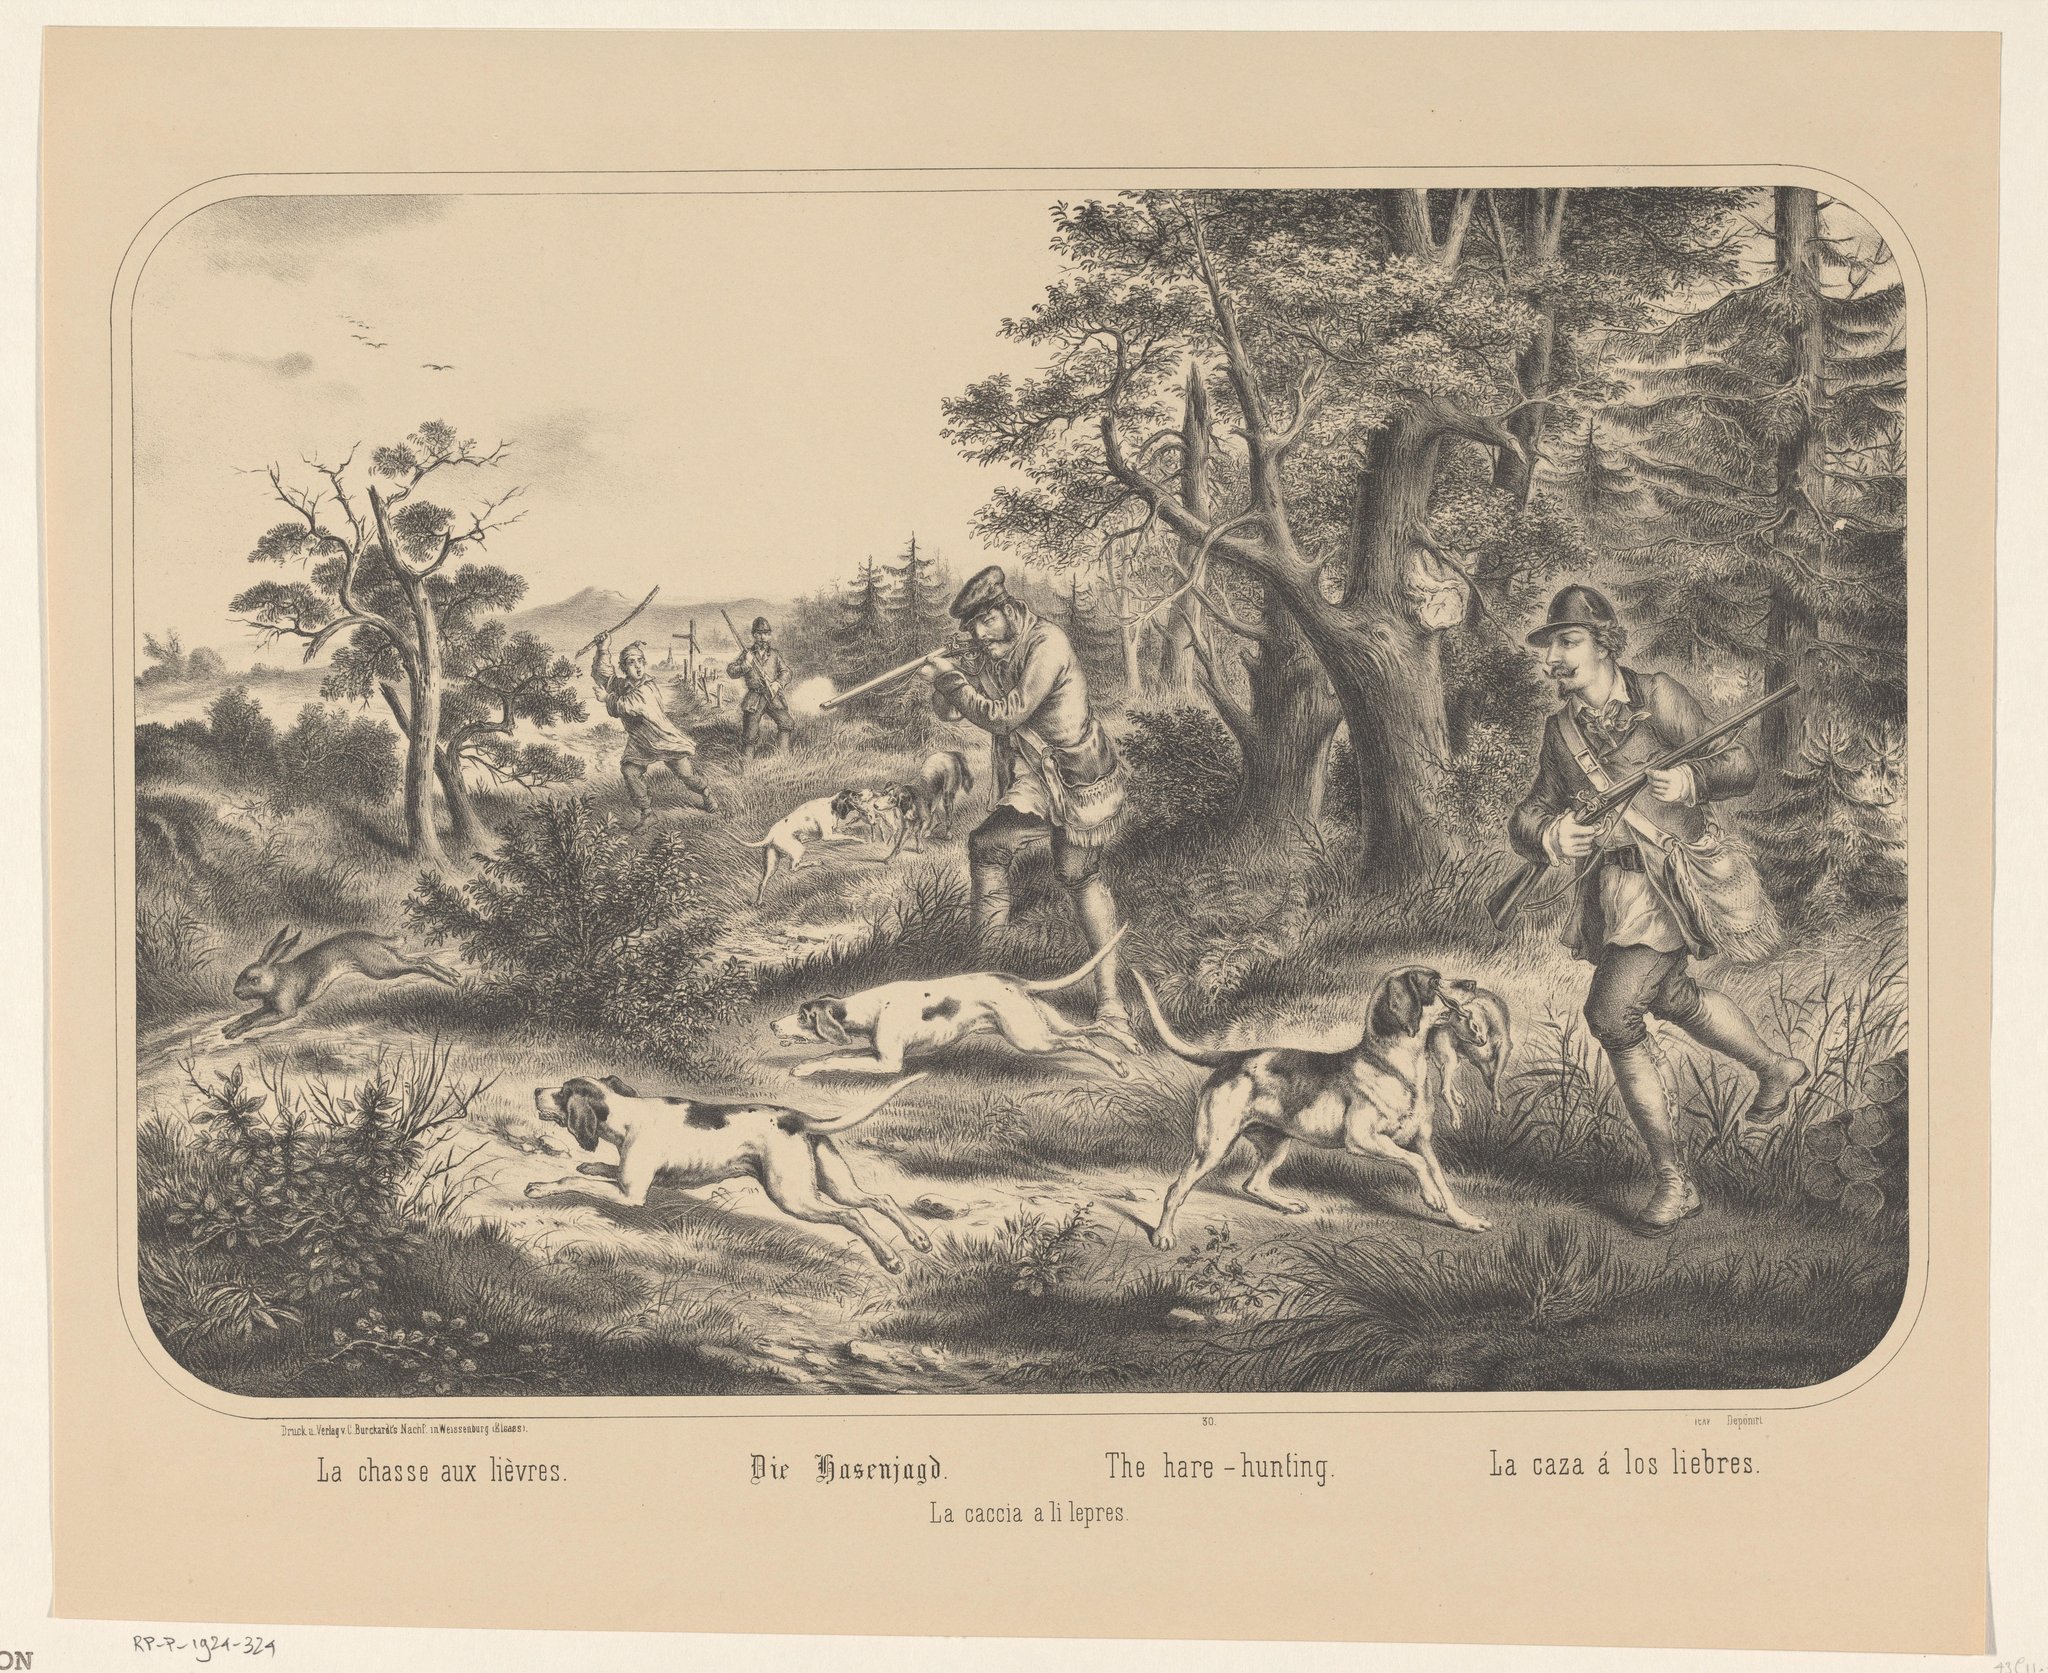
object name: print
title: De hazenjacht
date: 1850-1900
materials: paper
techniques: lithograph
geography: weissenburg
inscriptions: collector's mark: Lugt 2228, collector's mark: Lugt 2233